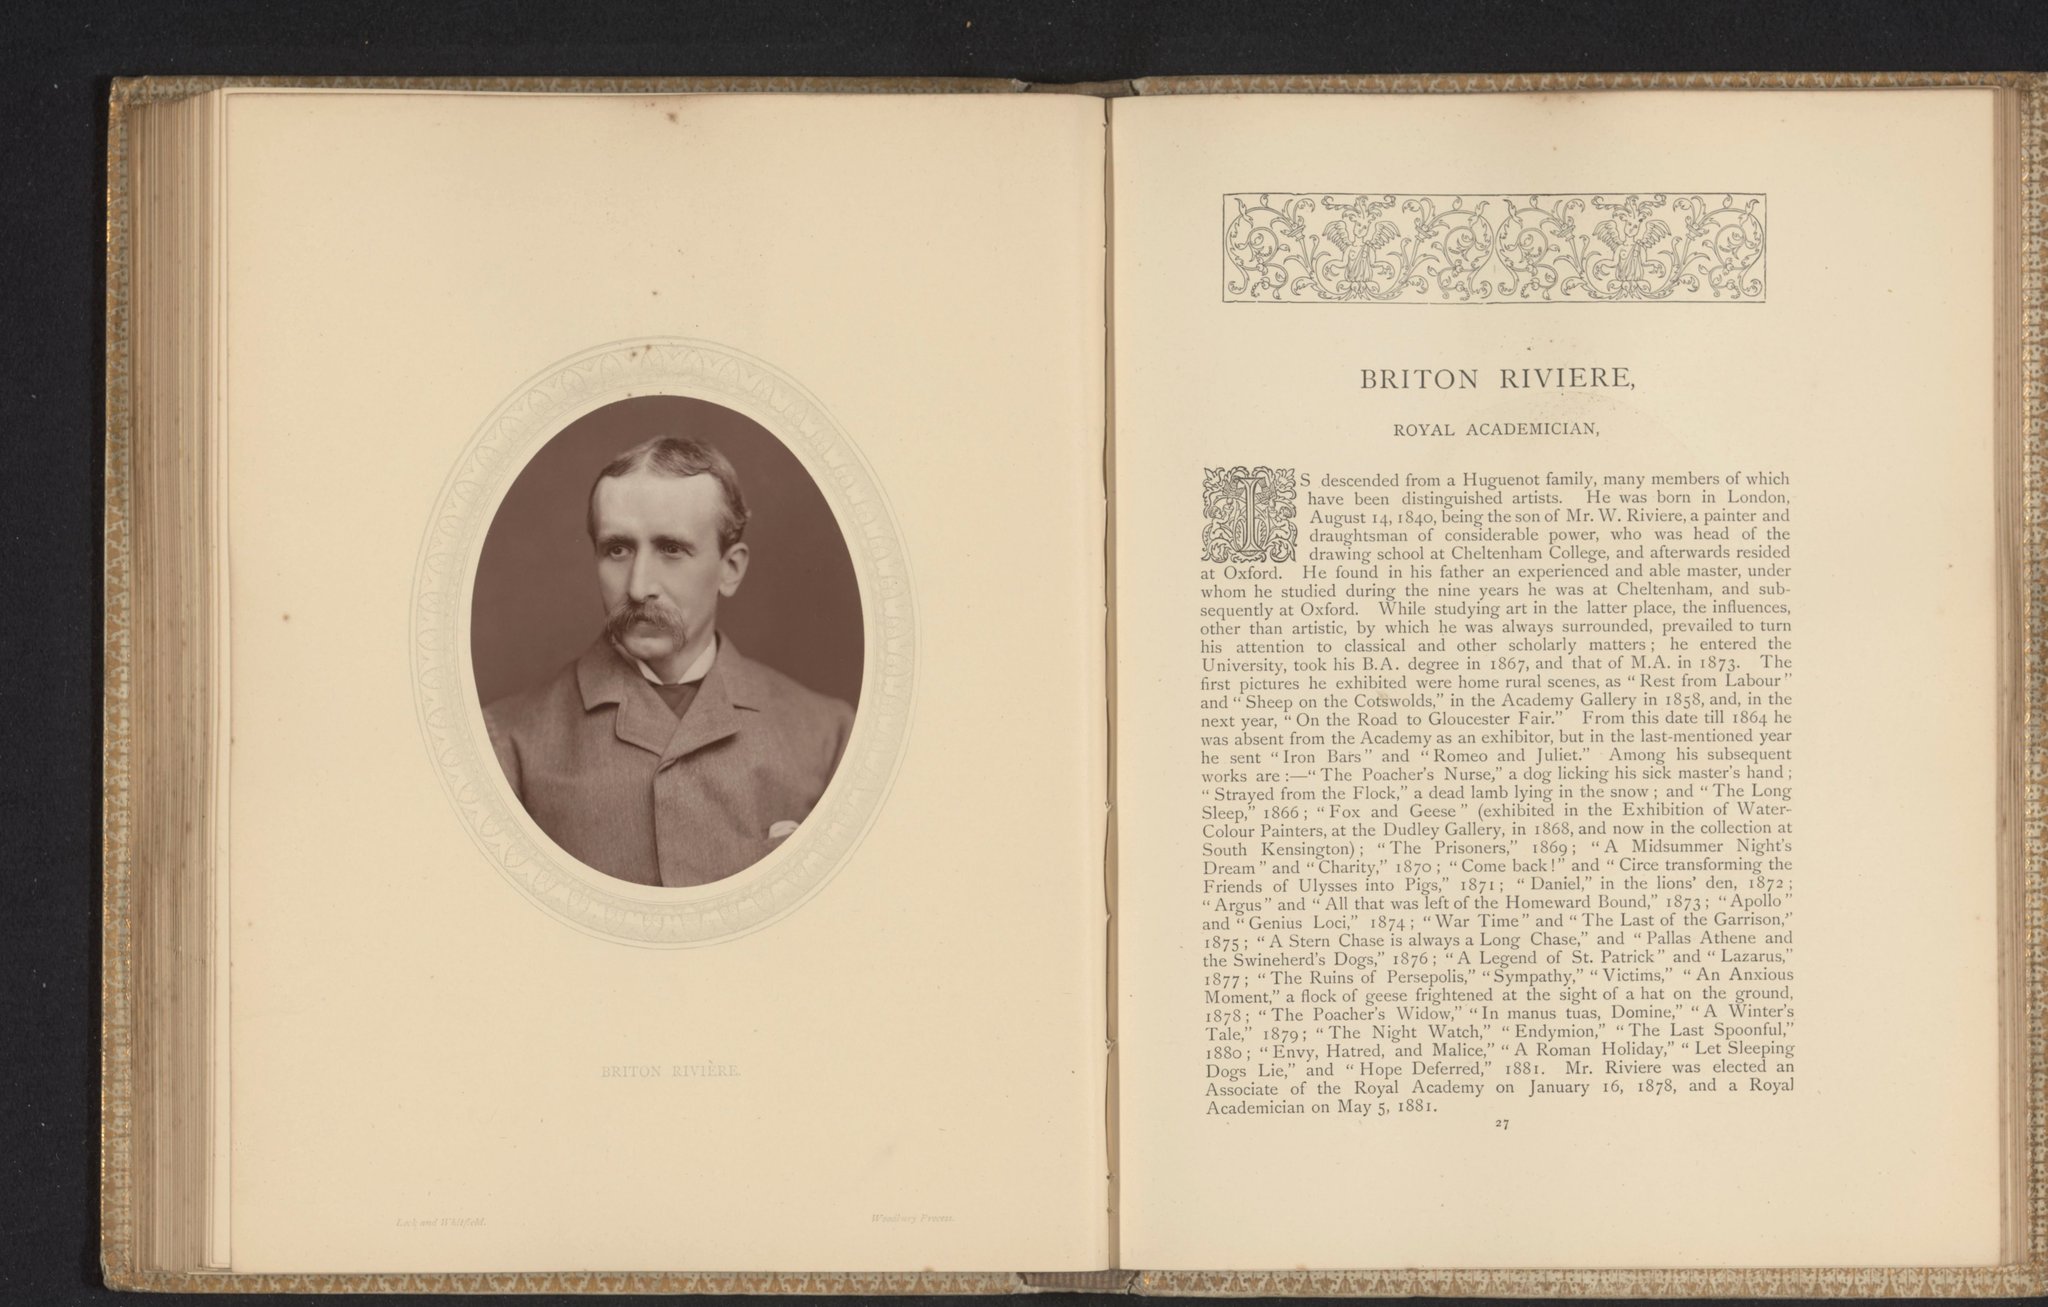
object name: page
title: Briton Rivière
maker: Anonymous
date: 1877-1882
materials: paper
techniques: woodburytype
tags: painter, portrait, self-portrait of painter, historical persons (portraits and scenes from the life) (+ (full) bust portrait)